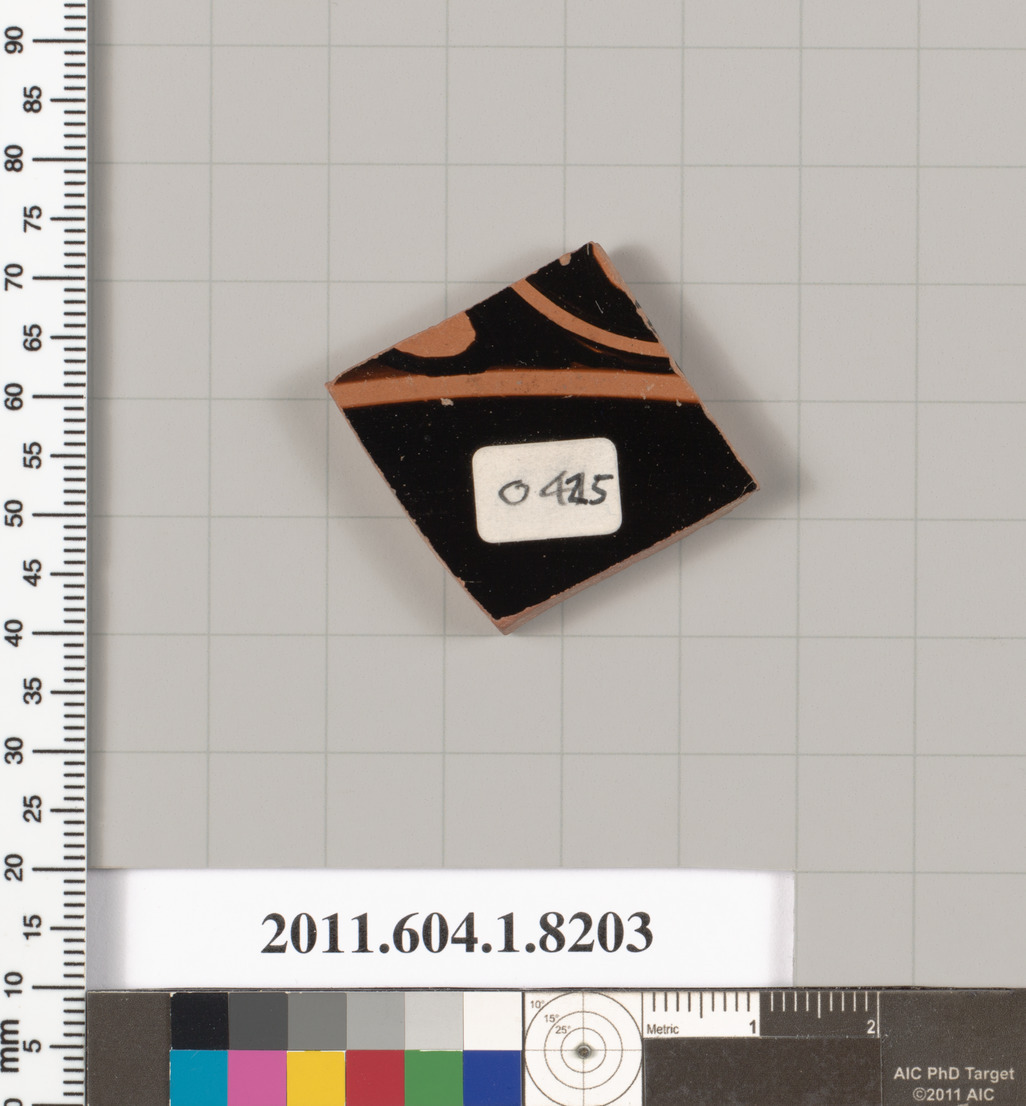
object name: kylix fragment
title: Terracotta fragment of a kylix (drinking cup)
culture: greek, attic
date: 520-510 BCE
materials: terracotta